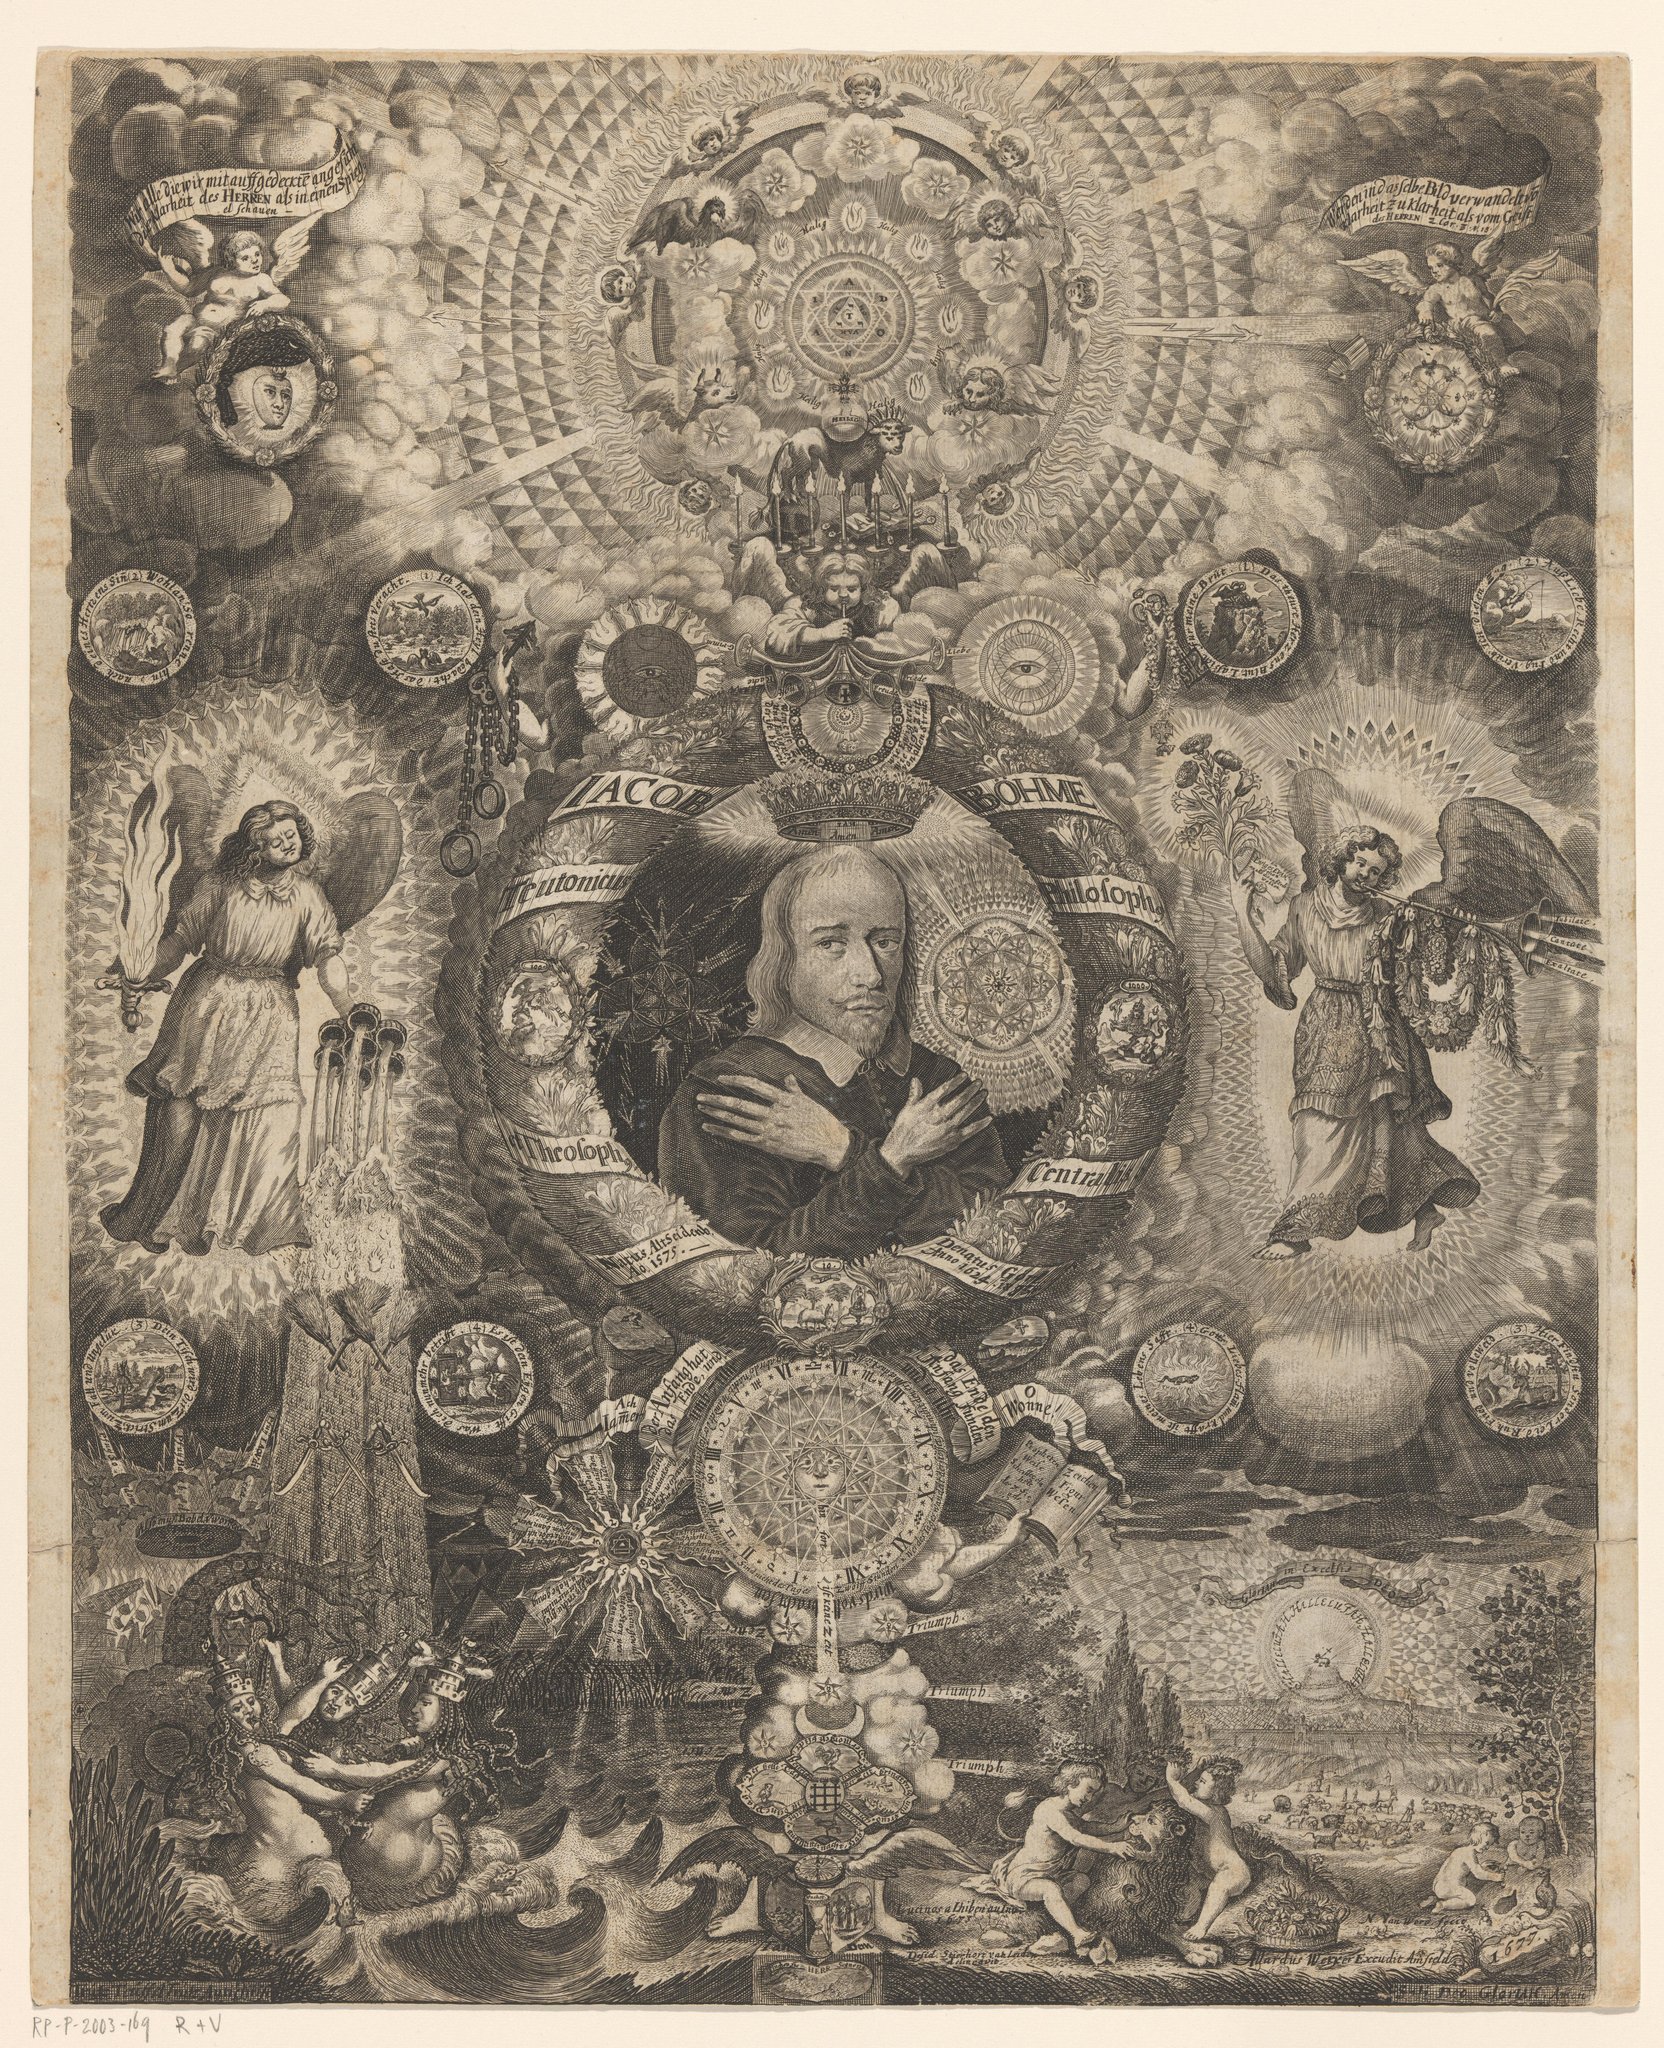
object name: print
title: Portret van de mysticus Jakob Böhme omringd door allegorische en emblematische voorstellingen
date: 1673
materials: paper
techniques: engraving, etching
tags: crown (symbol of sovereignty), horn, trumpet, cornet, trombone, tuba, historical persons, the four symbols of the evangelists, 'the apocalyptic beasts', garden of eden, paradise, war, allegory of time and eternity, abstract ideas and concepts (+ emblematical representation of concept), sodom and gomorrah burning, honour, glory; 'ampiezza della gloria', 'gloria', 'gloria de prencipi', 'gloria & honore', 'honore', 'sublimatà della gloria' (ripa), punishment; 'castigo', 'pena', 'punitione' (ripa), peace, angels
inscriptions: collector's mark: Lugt 2228, collector's mark: Lugt 2760